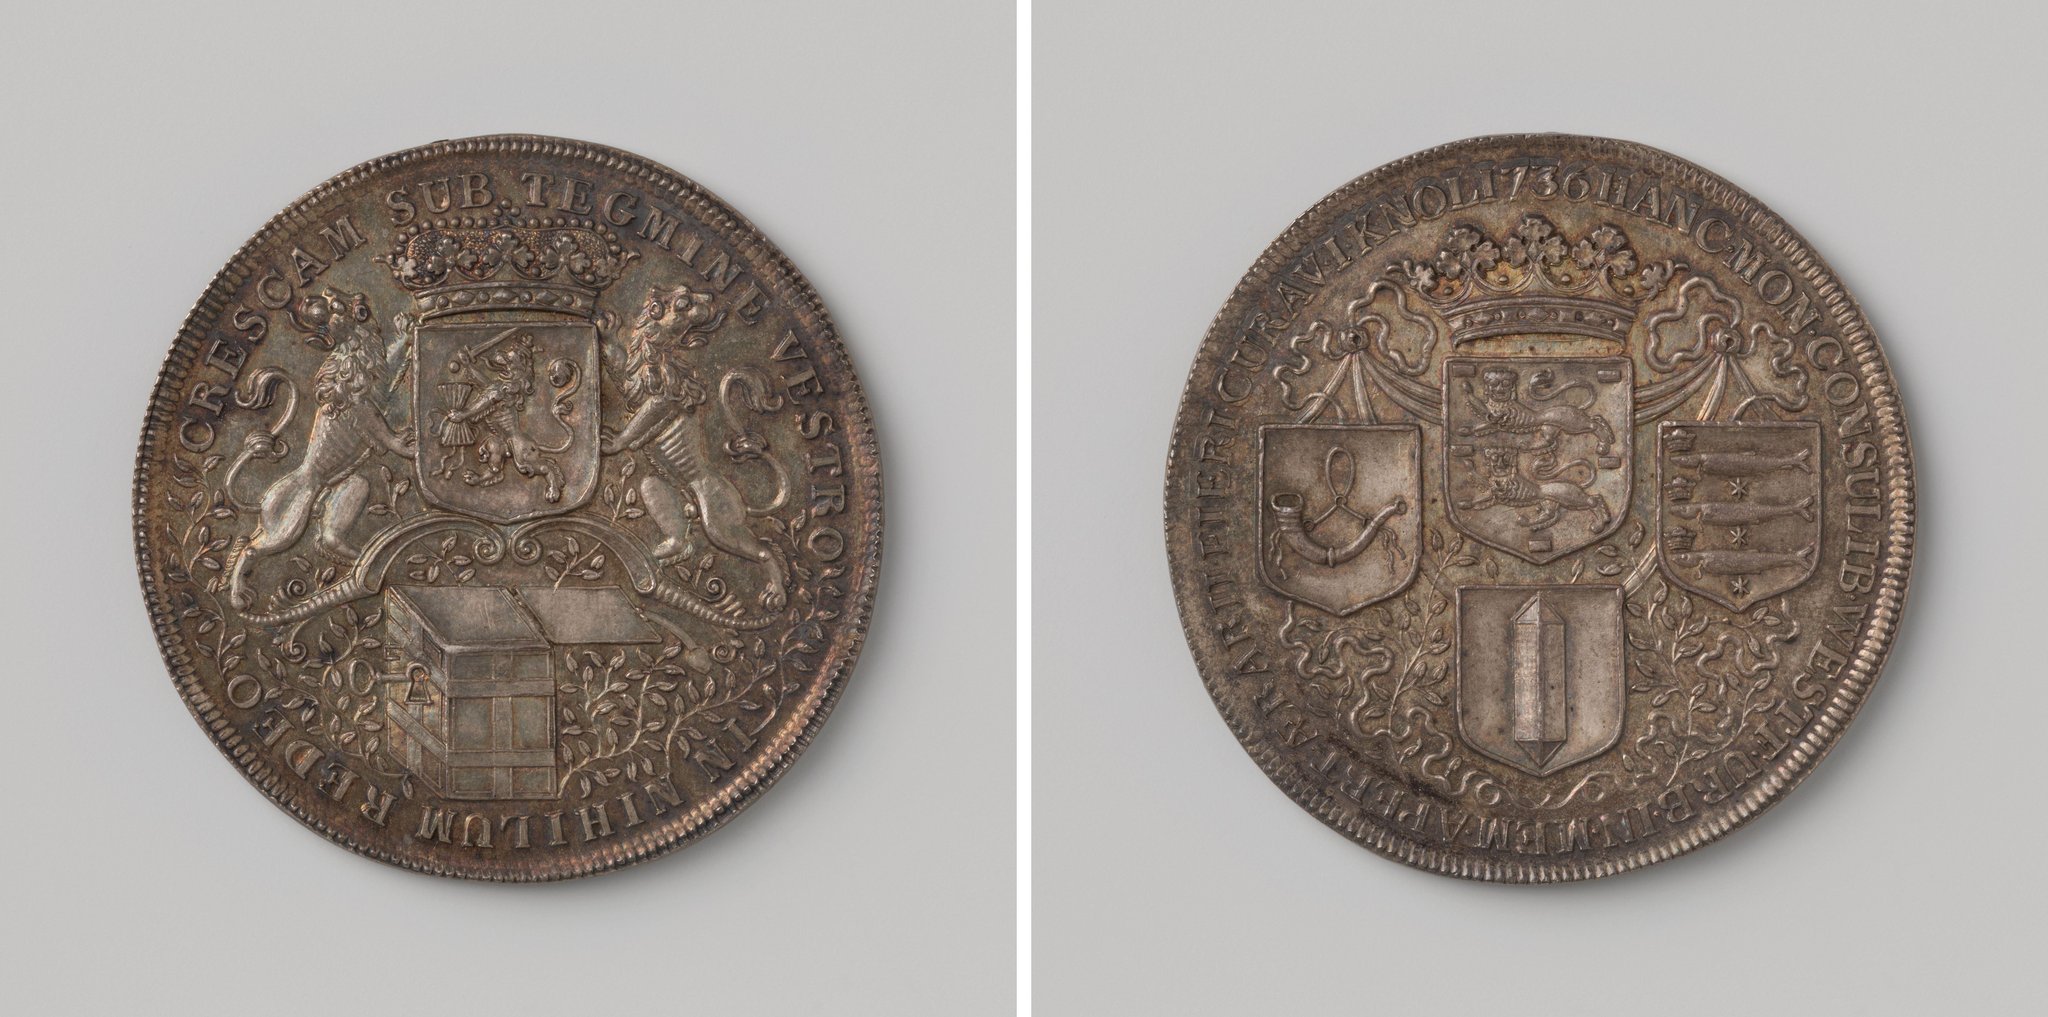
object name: history medal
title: Openen der Westfriese muntbus onder muntmeester J. Knol, penning vereerd aan de burgemeesters der westfriese steden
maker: jan knol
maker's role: mintmaster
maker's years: 1715-1751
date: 1736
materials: silver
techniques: striking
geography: west frisia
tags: mintmaster, jan knol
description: Zilveren penning. Voorzijde: gekroond wapenschild geflankeerd door twee leeuwen boven geopende muntbus temidden van olijftakken binnen omschrift. Keerzijde: gekroond wapenschild, omgeven door drie met lint verbonden wapenschilden, daartussen olijftakken binnen omschrift